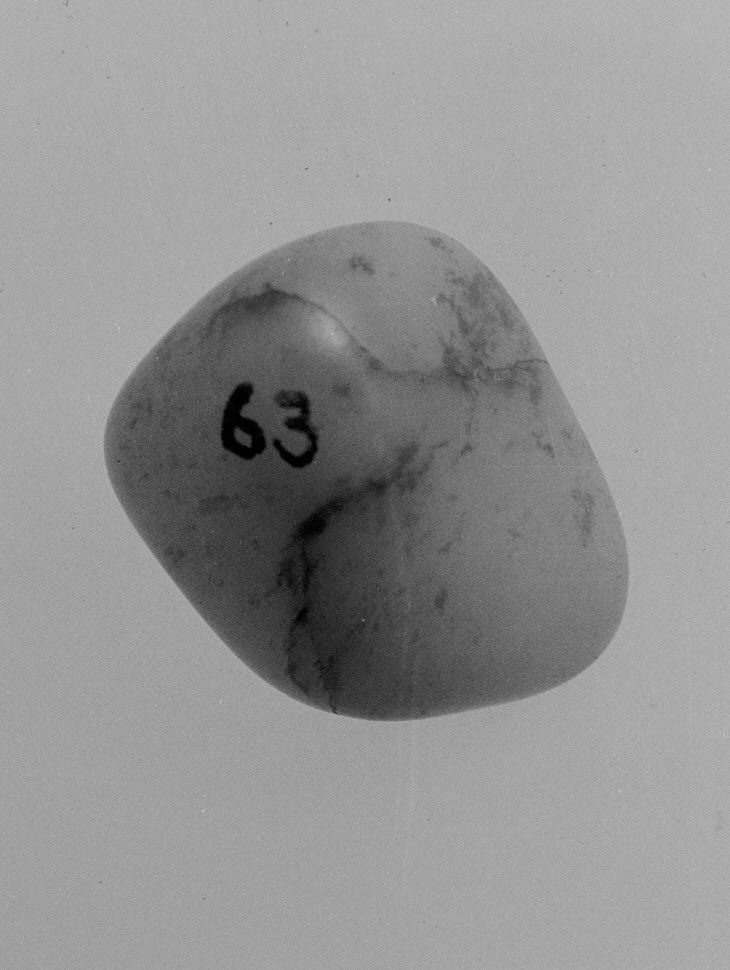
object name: pebble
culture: chinese or turkestani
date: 1902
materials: jade